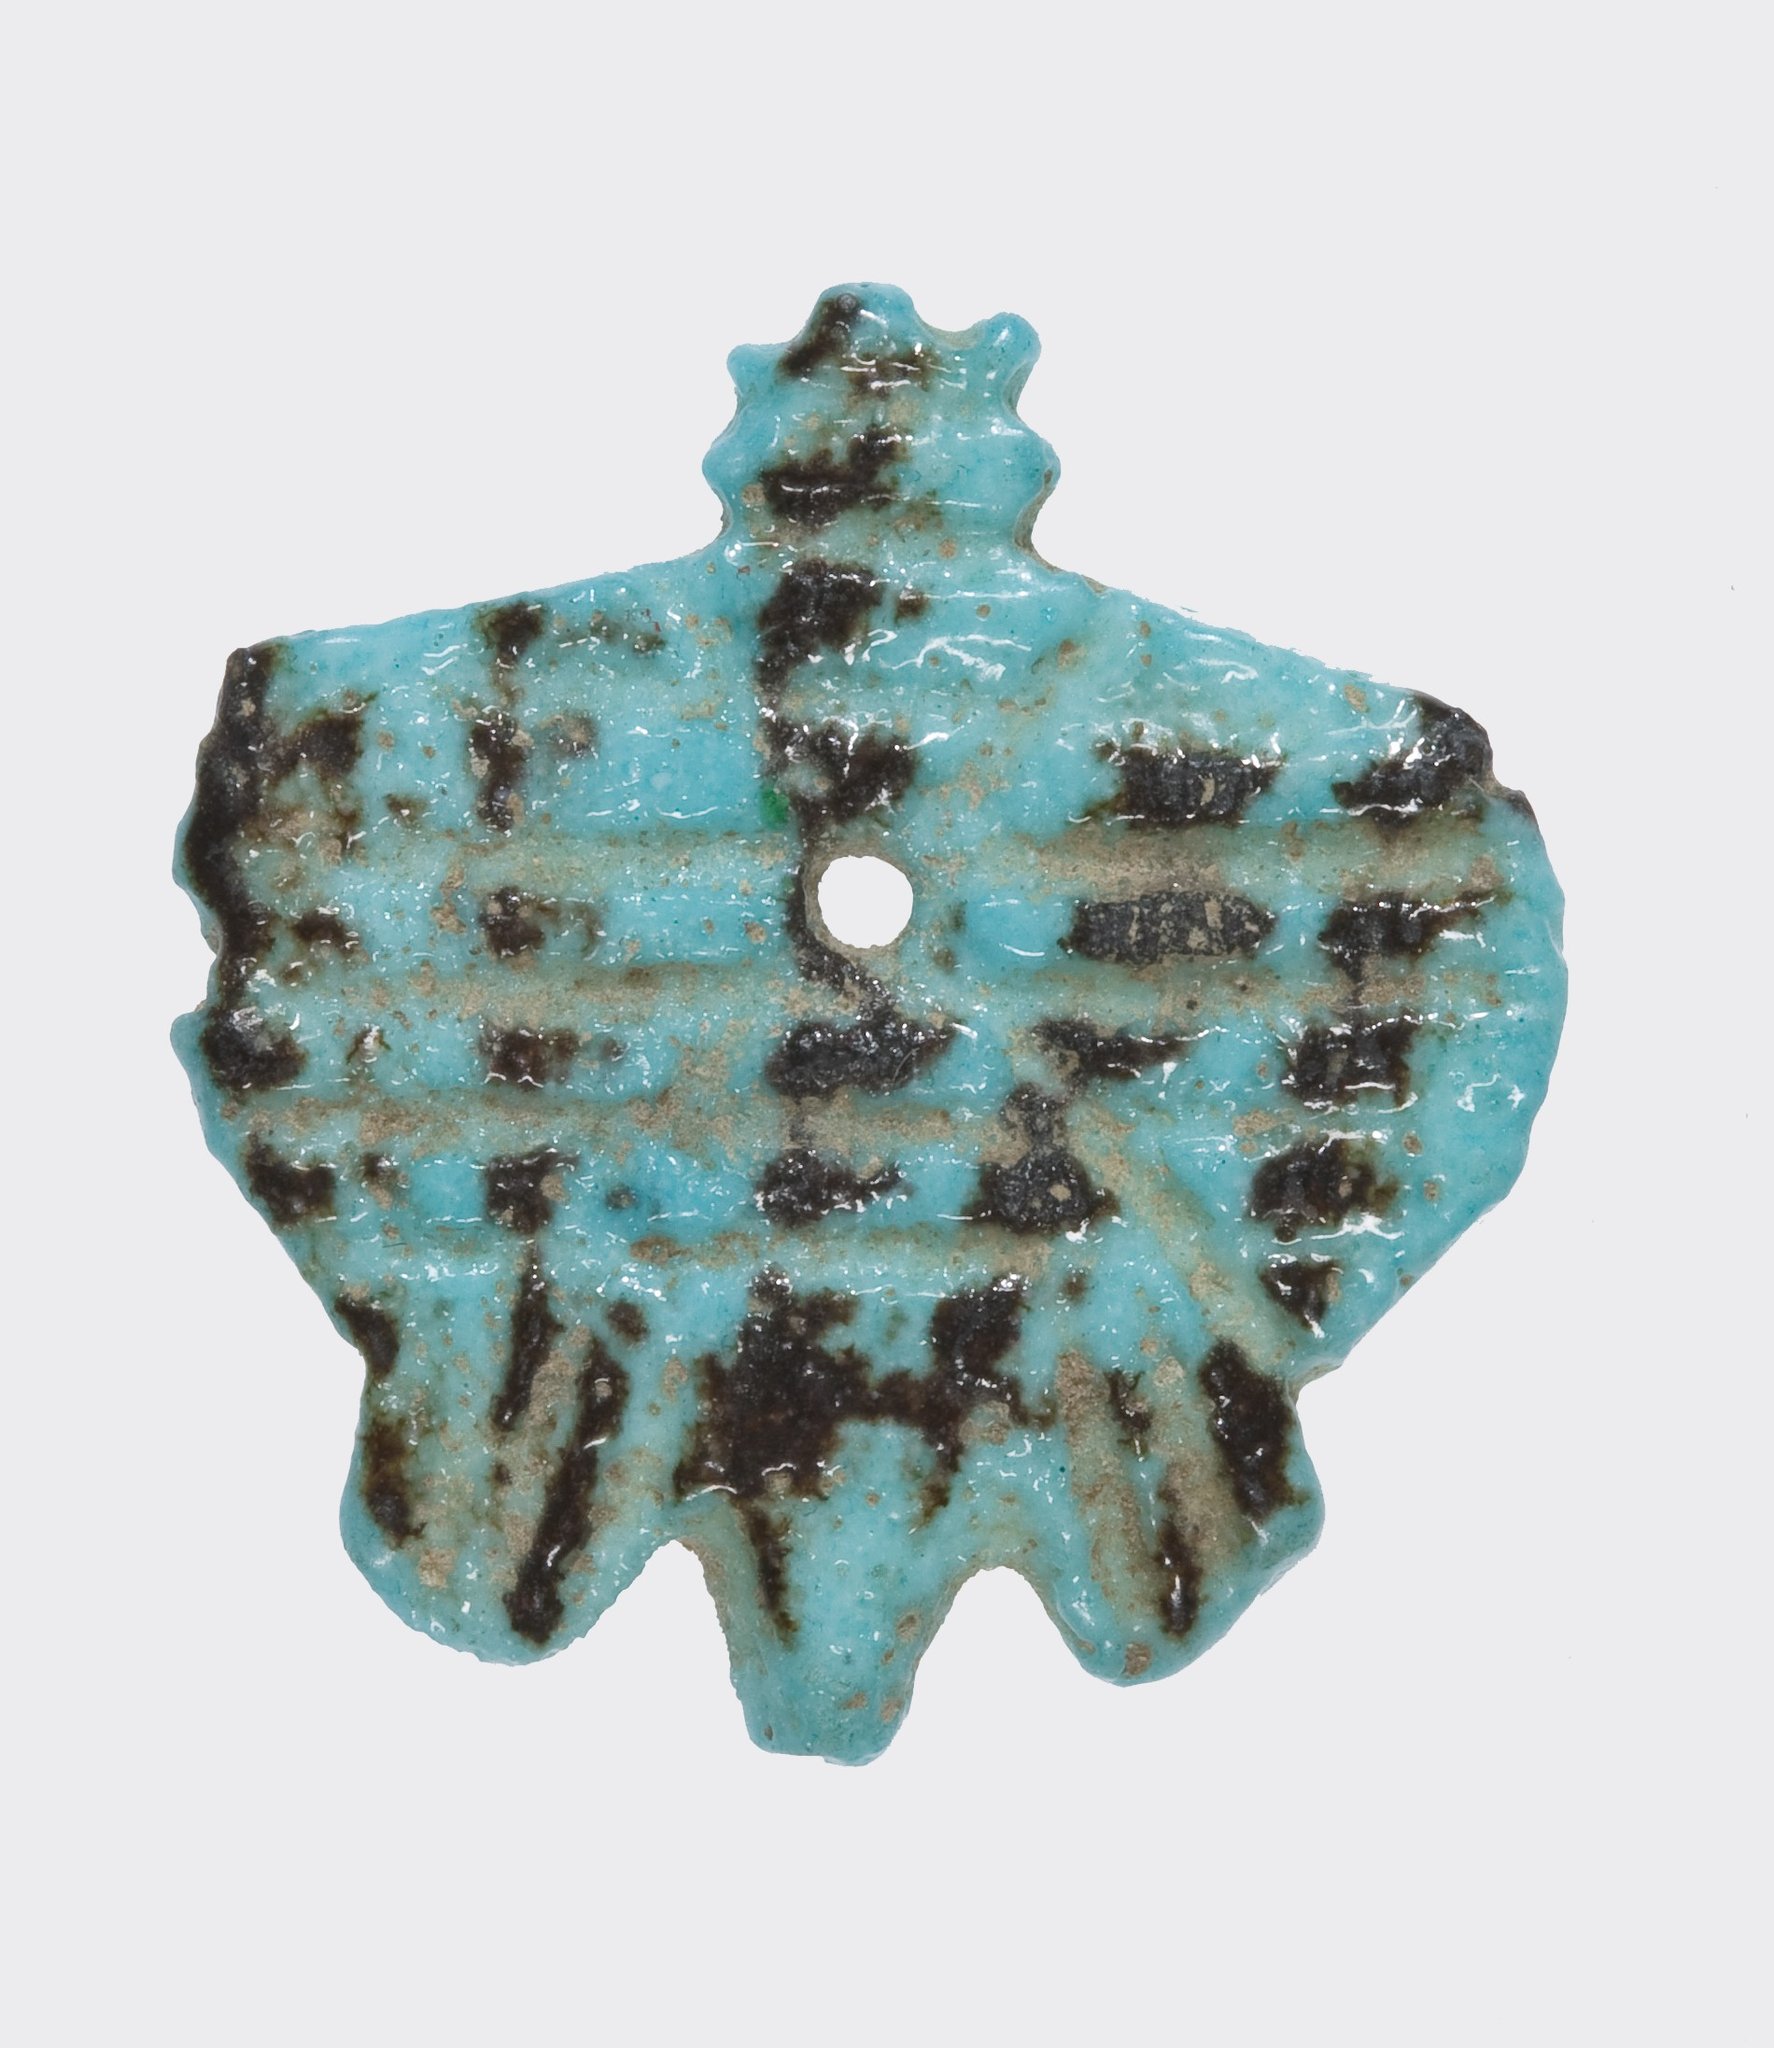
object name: amulet, butterfly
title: Butterfly amulet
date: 1981-1640 BCE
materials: faience, paint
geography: egypt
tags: butterflies